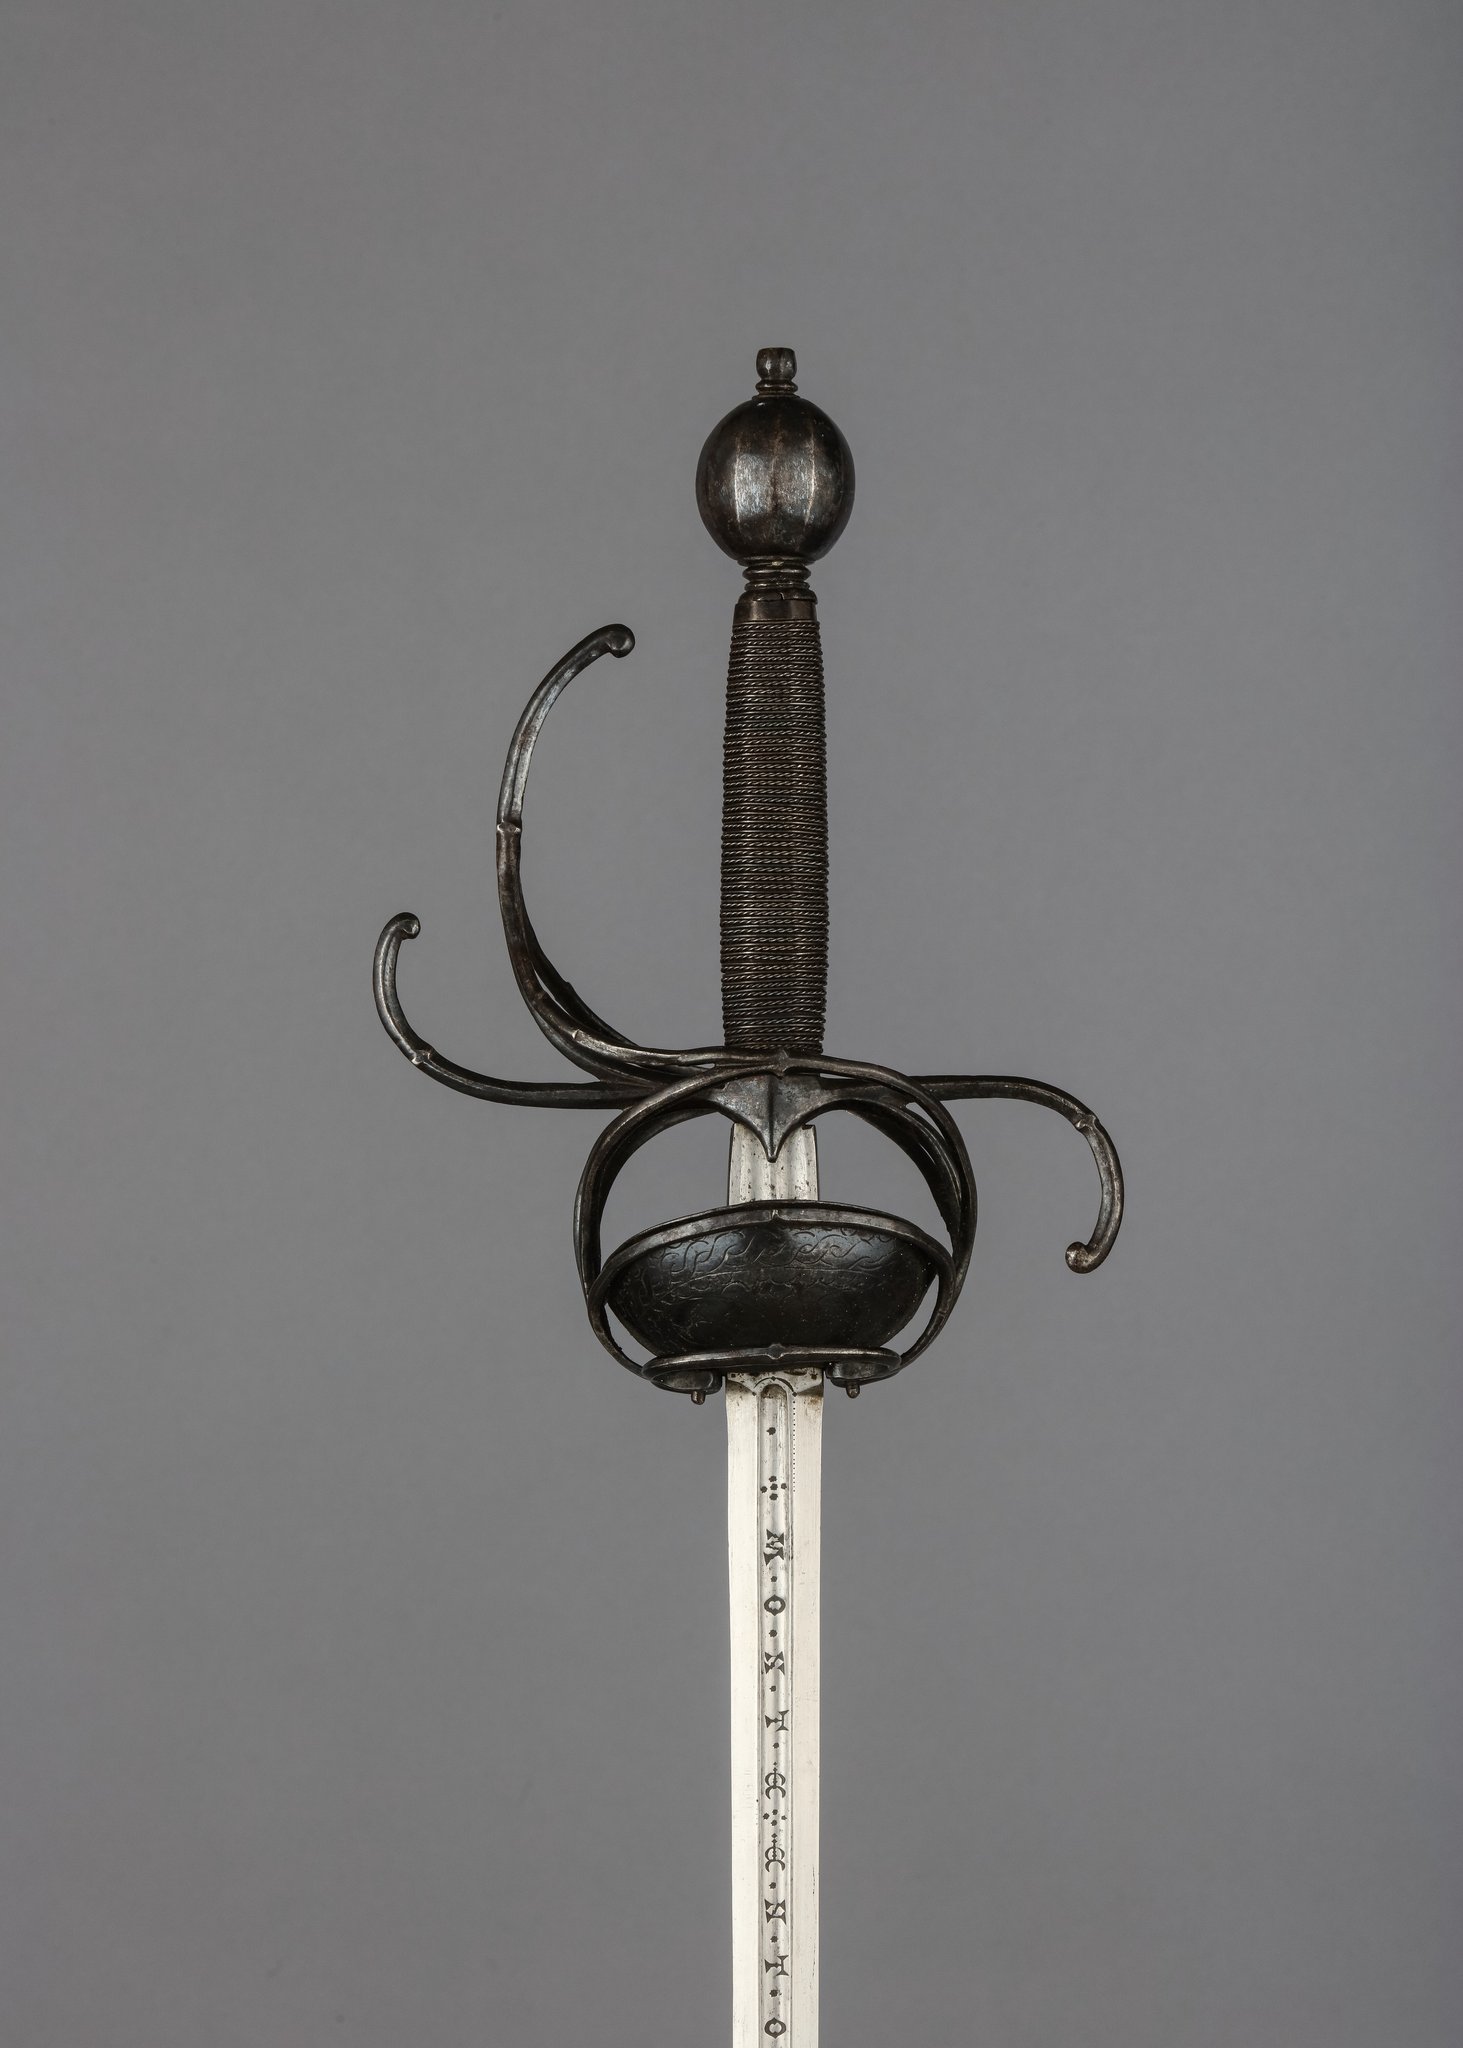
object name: rapier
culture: spanish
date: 1600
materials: iron, steel, metal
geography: spain